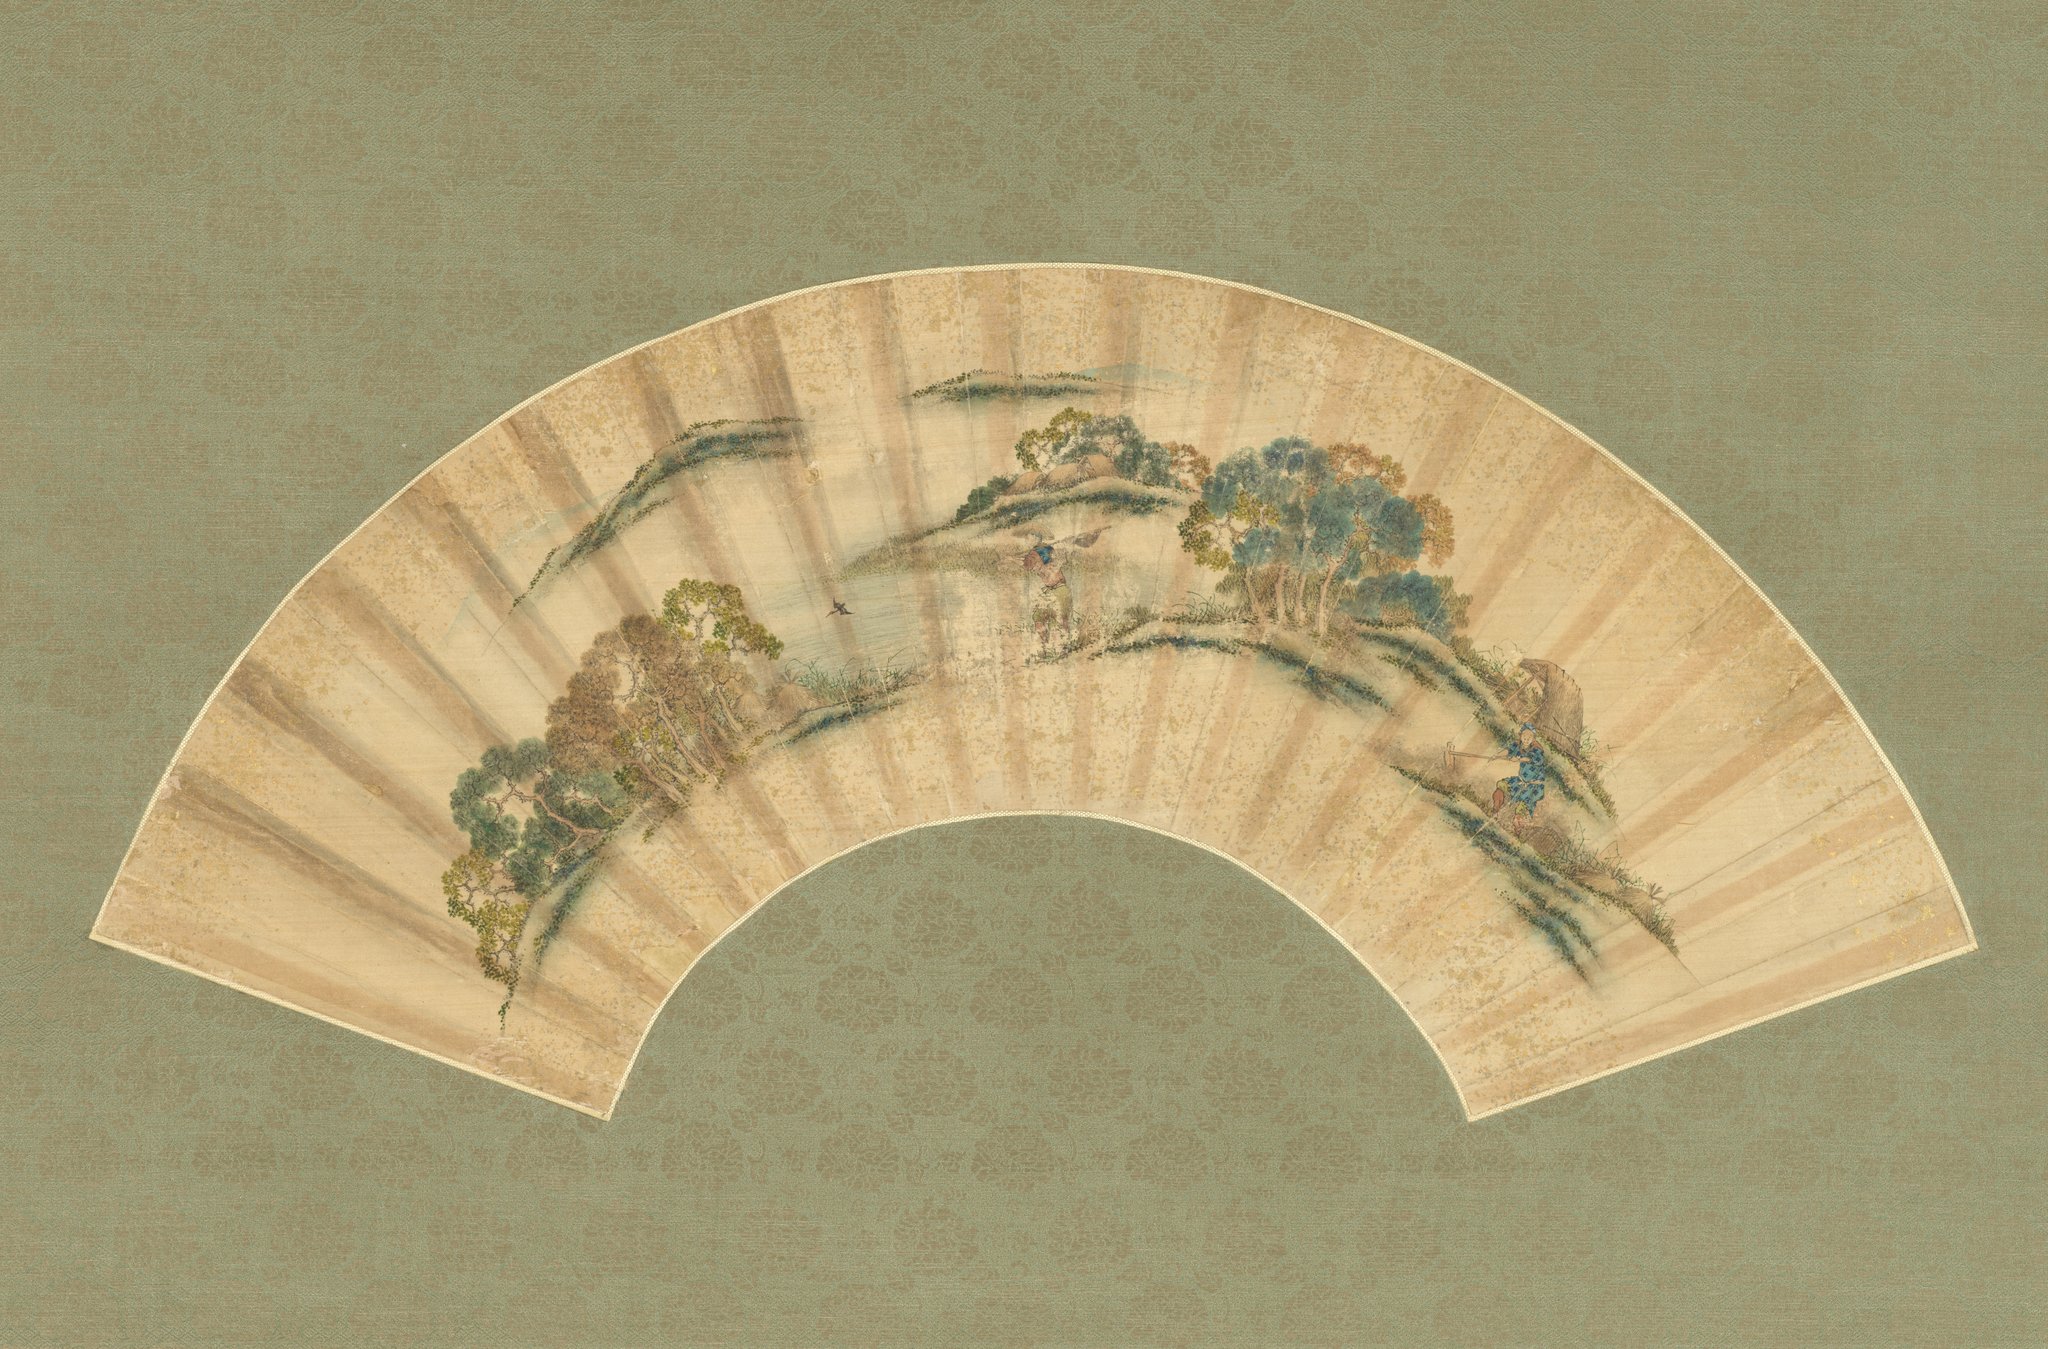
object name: hanging scroll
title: Spring Farming Scene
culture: japanese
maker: katsushika isai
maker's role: artist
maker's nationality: japanese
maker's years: 1821-1880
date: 1821-1868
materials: ink, silk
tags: landscapes